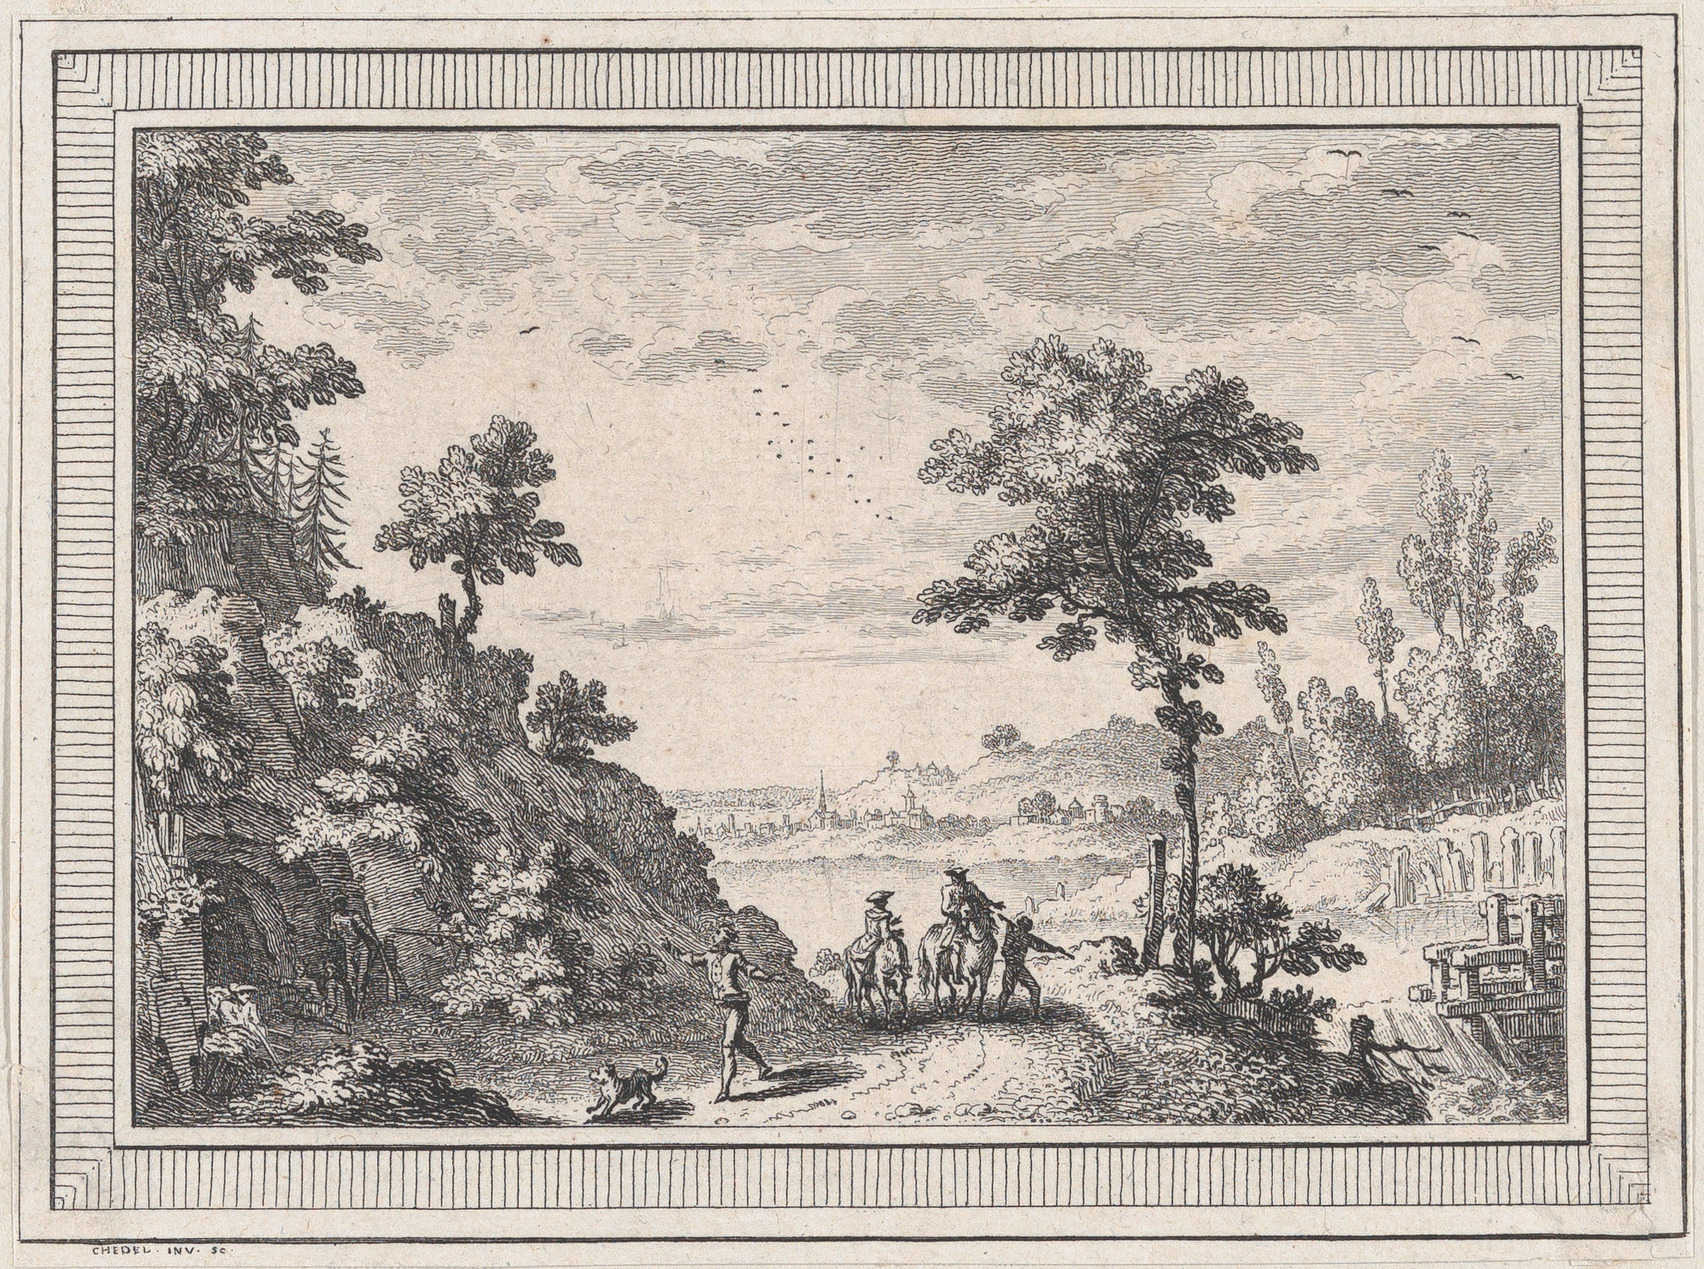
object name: print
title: Landscape, from a series of six landscapes dedicated to Madame La Marquise de Pompadour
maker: quentin pierre chedel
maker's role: artist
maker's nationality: french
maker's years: 1705-1763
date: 1701-1800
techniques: etching